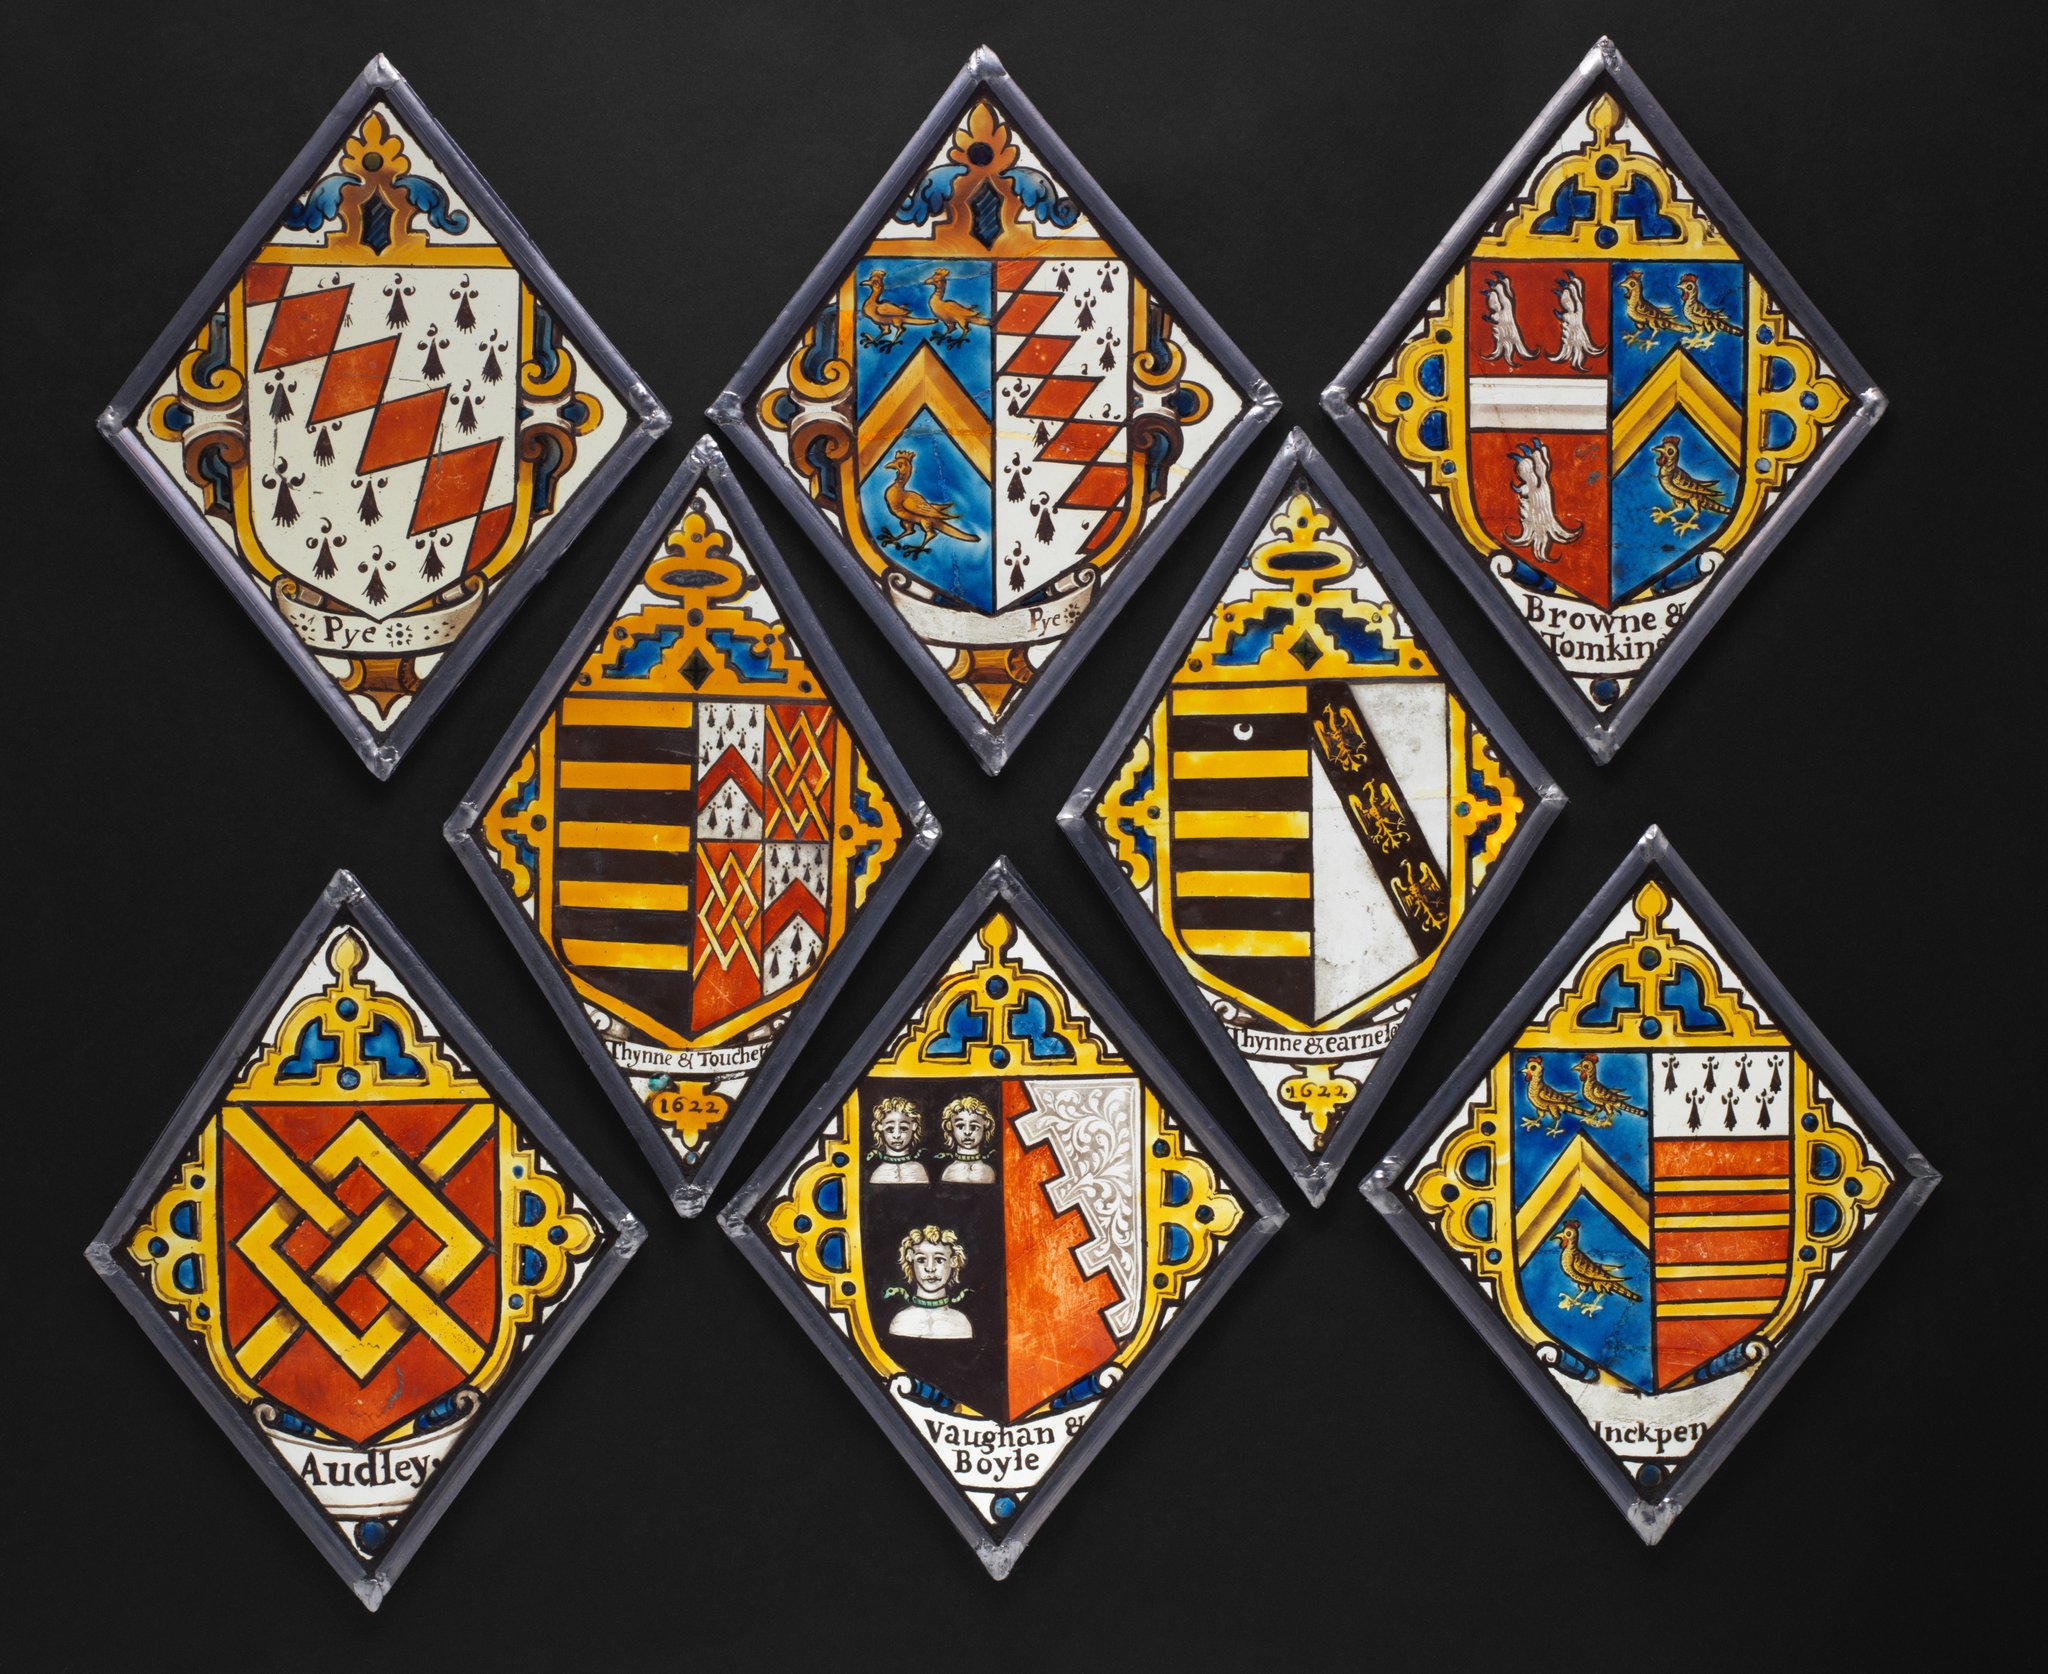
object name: panel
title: Eight heraldic quarries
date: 1622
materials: glass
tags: coat of arms